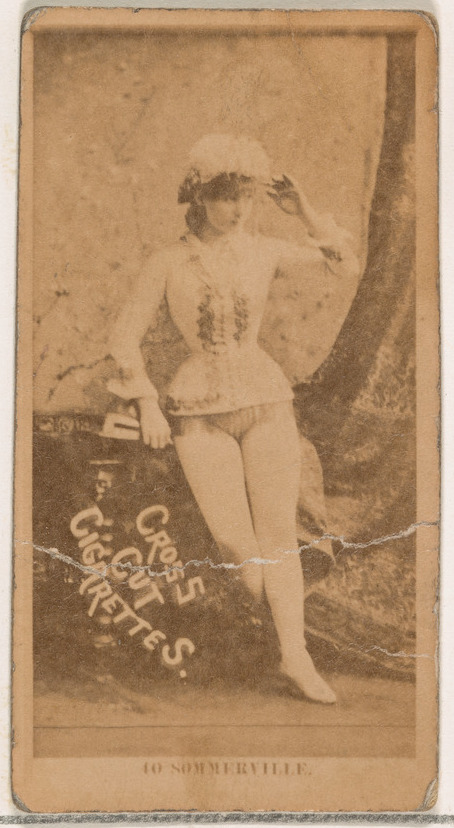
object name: print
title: Card Number 40, Sommerville, from the Actors and Actresses series (N145-2) issued by Duke Sons & Co. to promote Cross Cut Cigarettes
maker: w. duke, sons & co.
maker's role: publisher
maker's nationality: american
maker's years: 1870-1920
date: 1880-1889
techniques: albumen silver print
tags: portraits,women,actresses